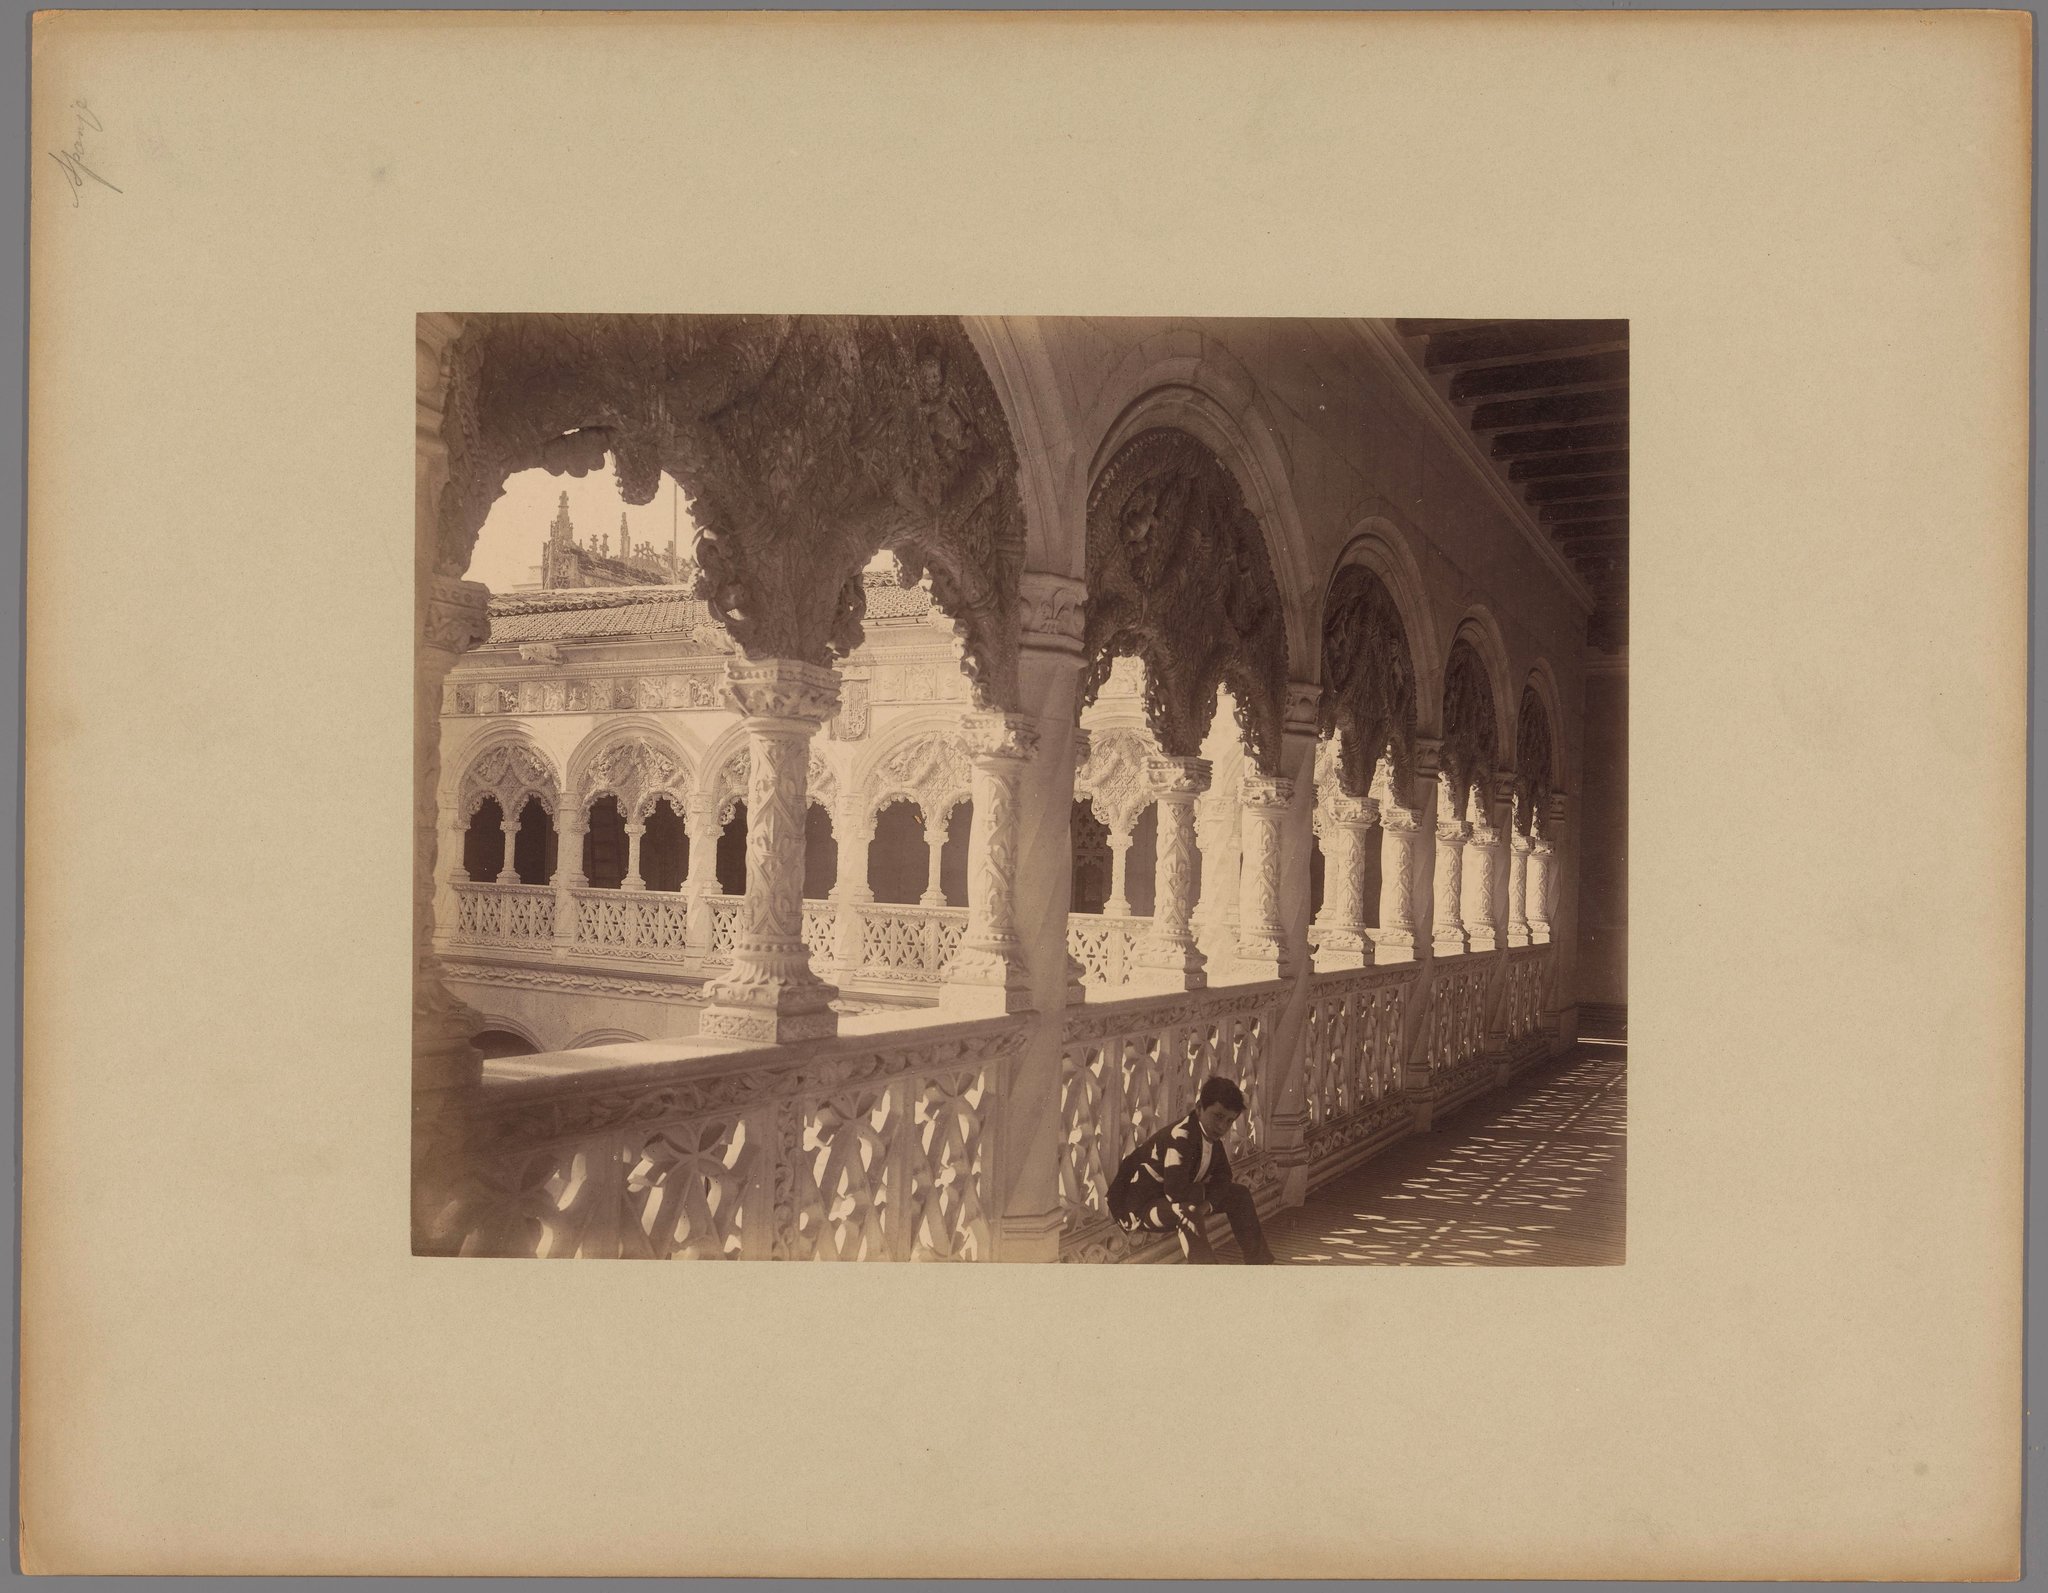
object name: photograph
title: Zuilengang in een gebouw (vermoedelijk) in Spanje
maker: Anonymous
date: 1875-1900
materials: cardboard, photographic support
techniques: albumen print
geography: spain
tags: column, pillar ~ architecture, arcade ~ architecture, spain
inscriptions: inscription: ‘Spanje’, collector's mark: Lugt 3937